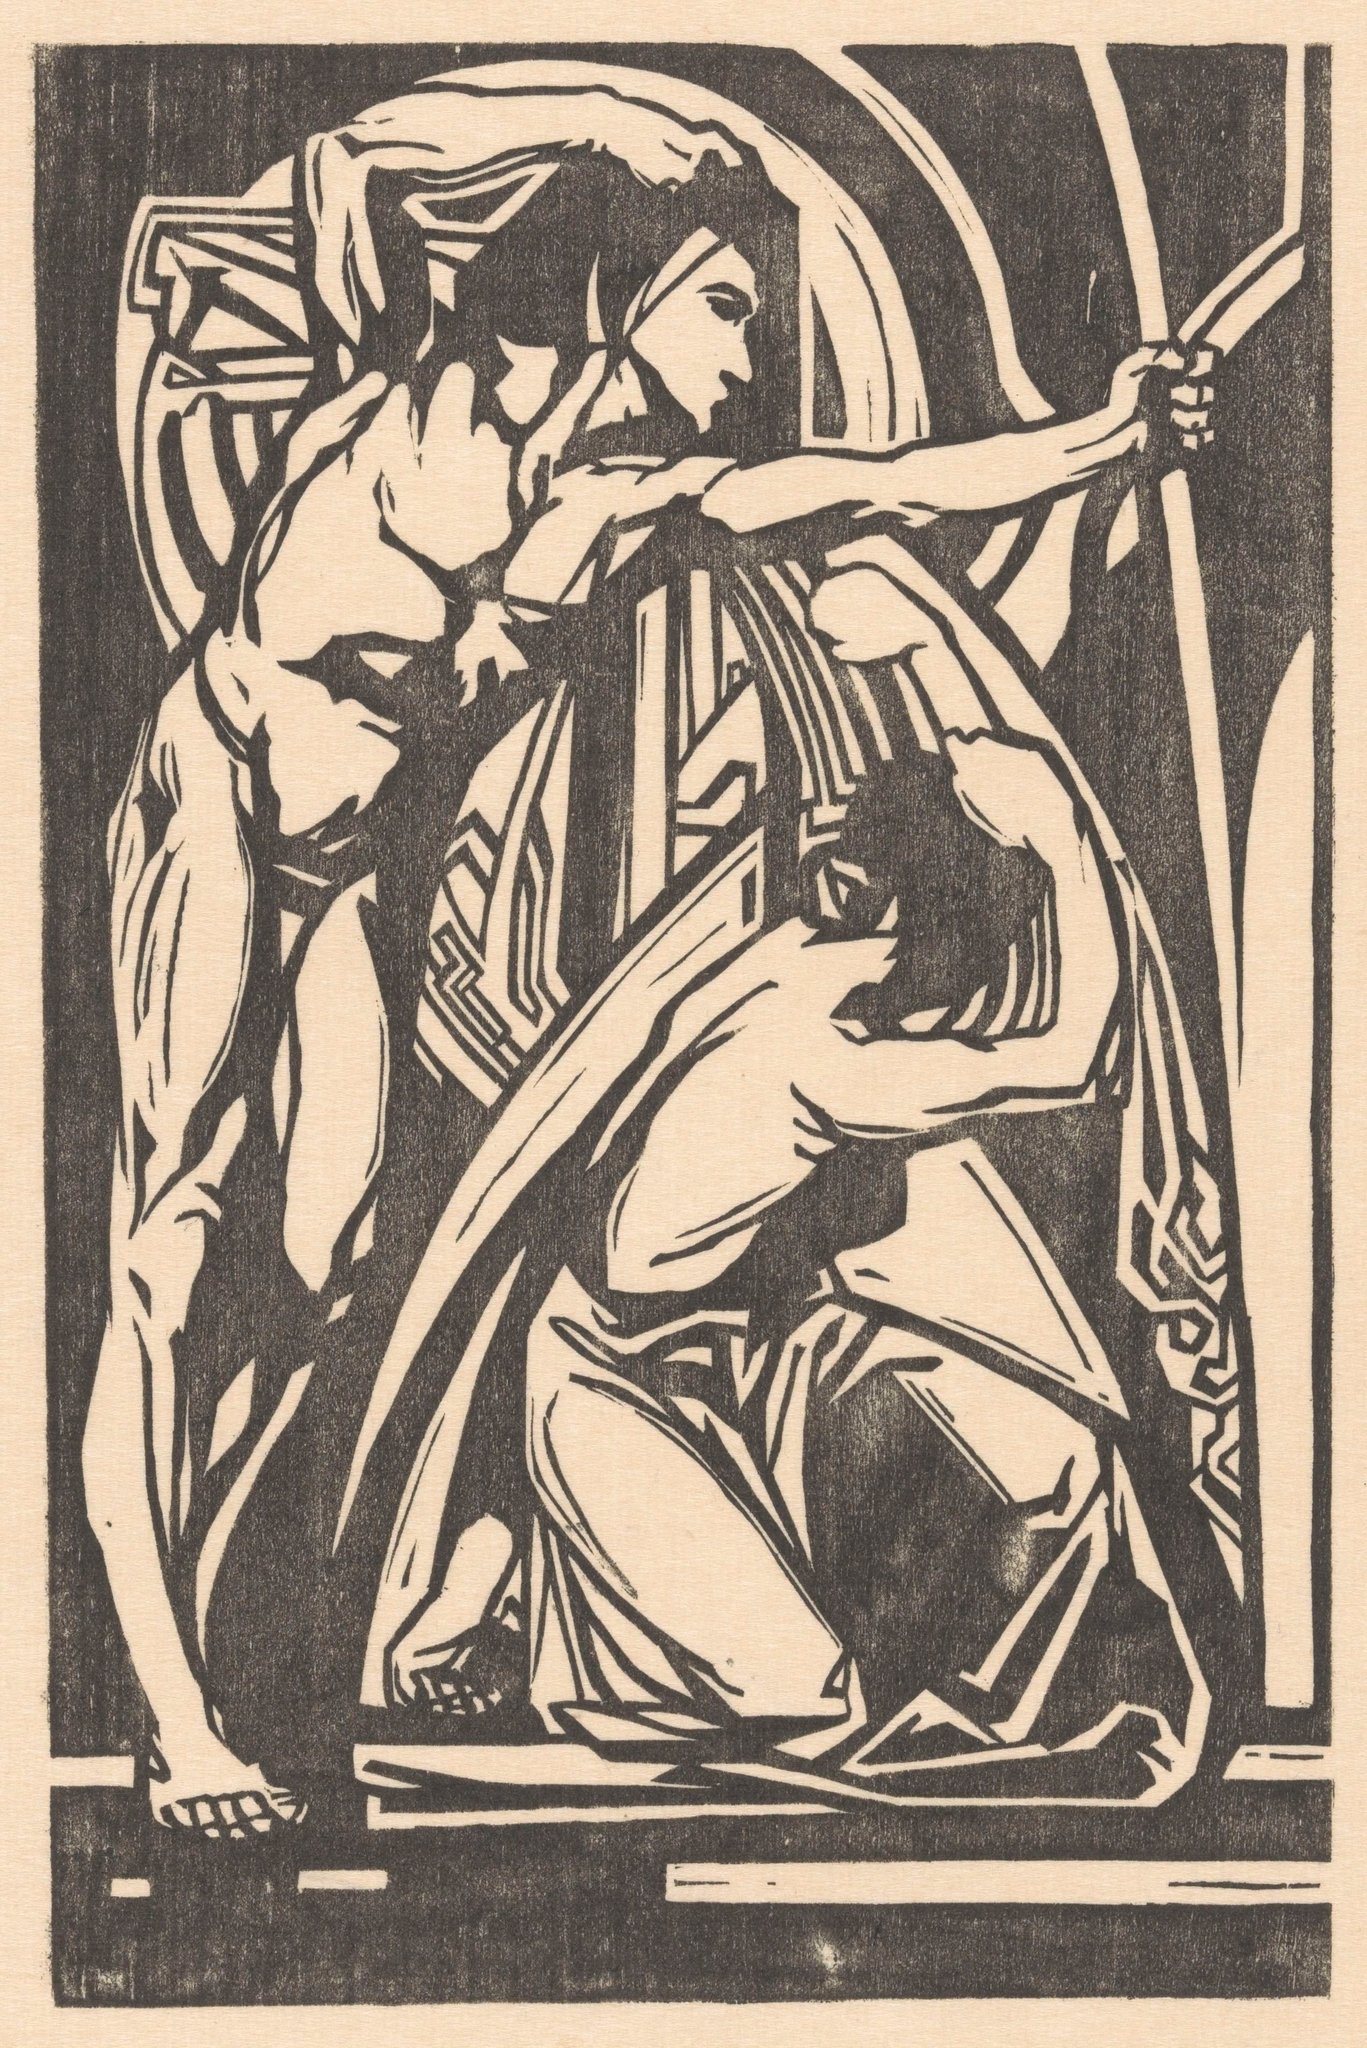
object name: print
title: Staande man en knielende vrouw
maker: johannes josephus aarts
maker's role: draughtsman, print maker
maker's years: 1871-1934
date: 1881-1934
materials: paper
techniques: woodcut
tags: (showing oneself) undressed, quasi-nude, kneeling figure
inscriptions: collector's mark: Lugt 2228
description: Een naakte, staande man, die zijn armen zo houdt alsof hij met pijl en boog schiet. Rechts van hem een halfnaakte, knielende vrouw, die twee gebalde vuisten in de lucht steekt.